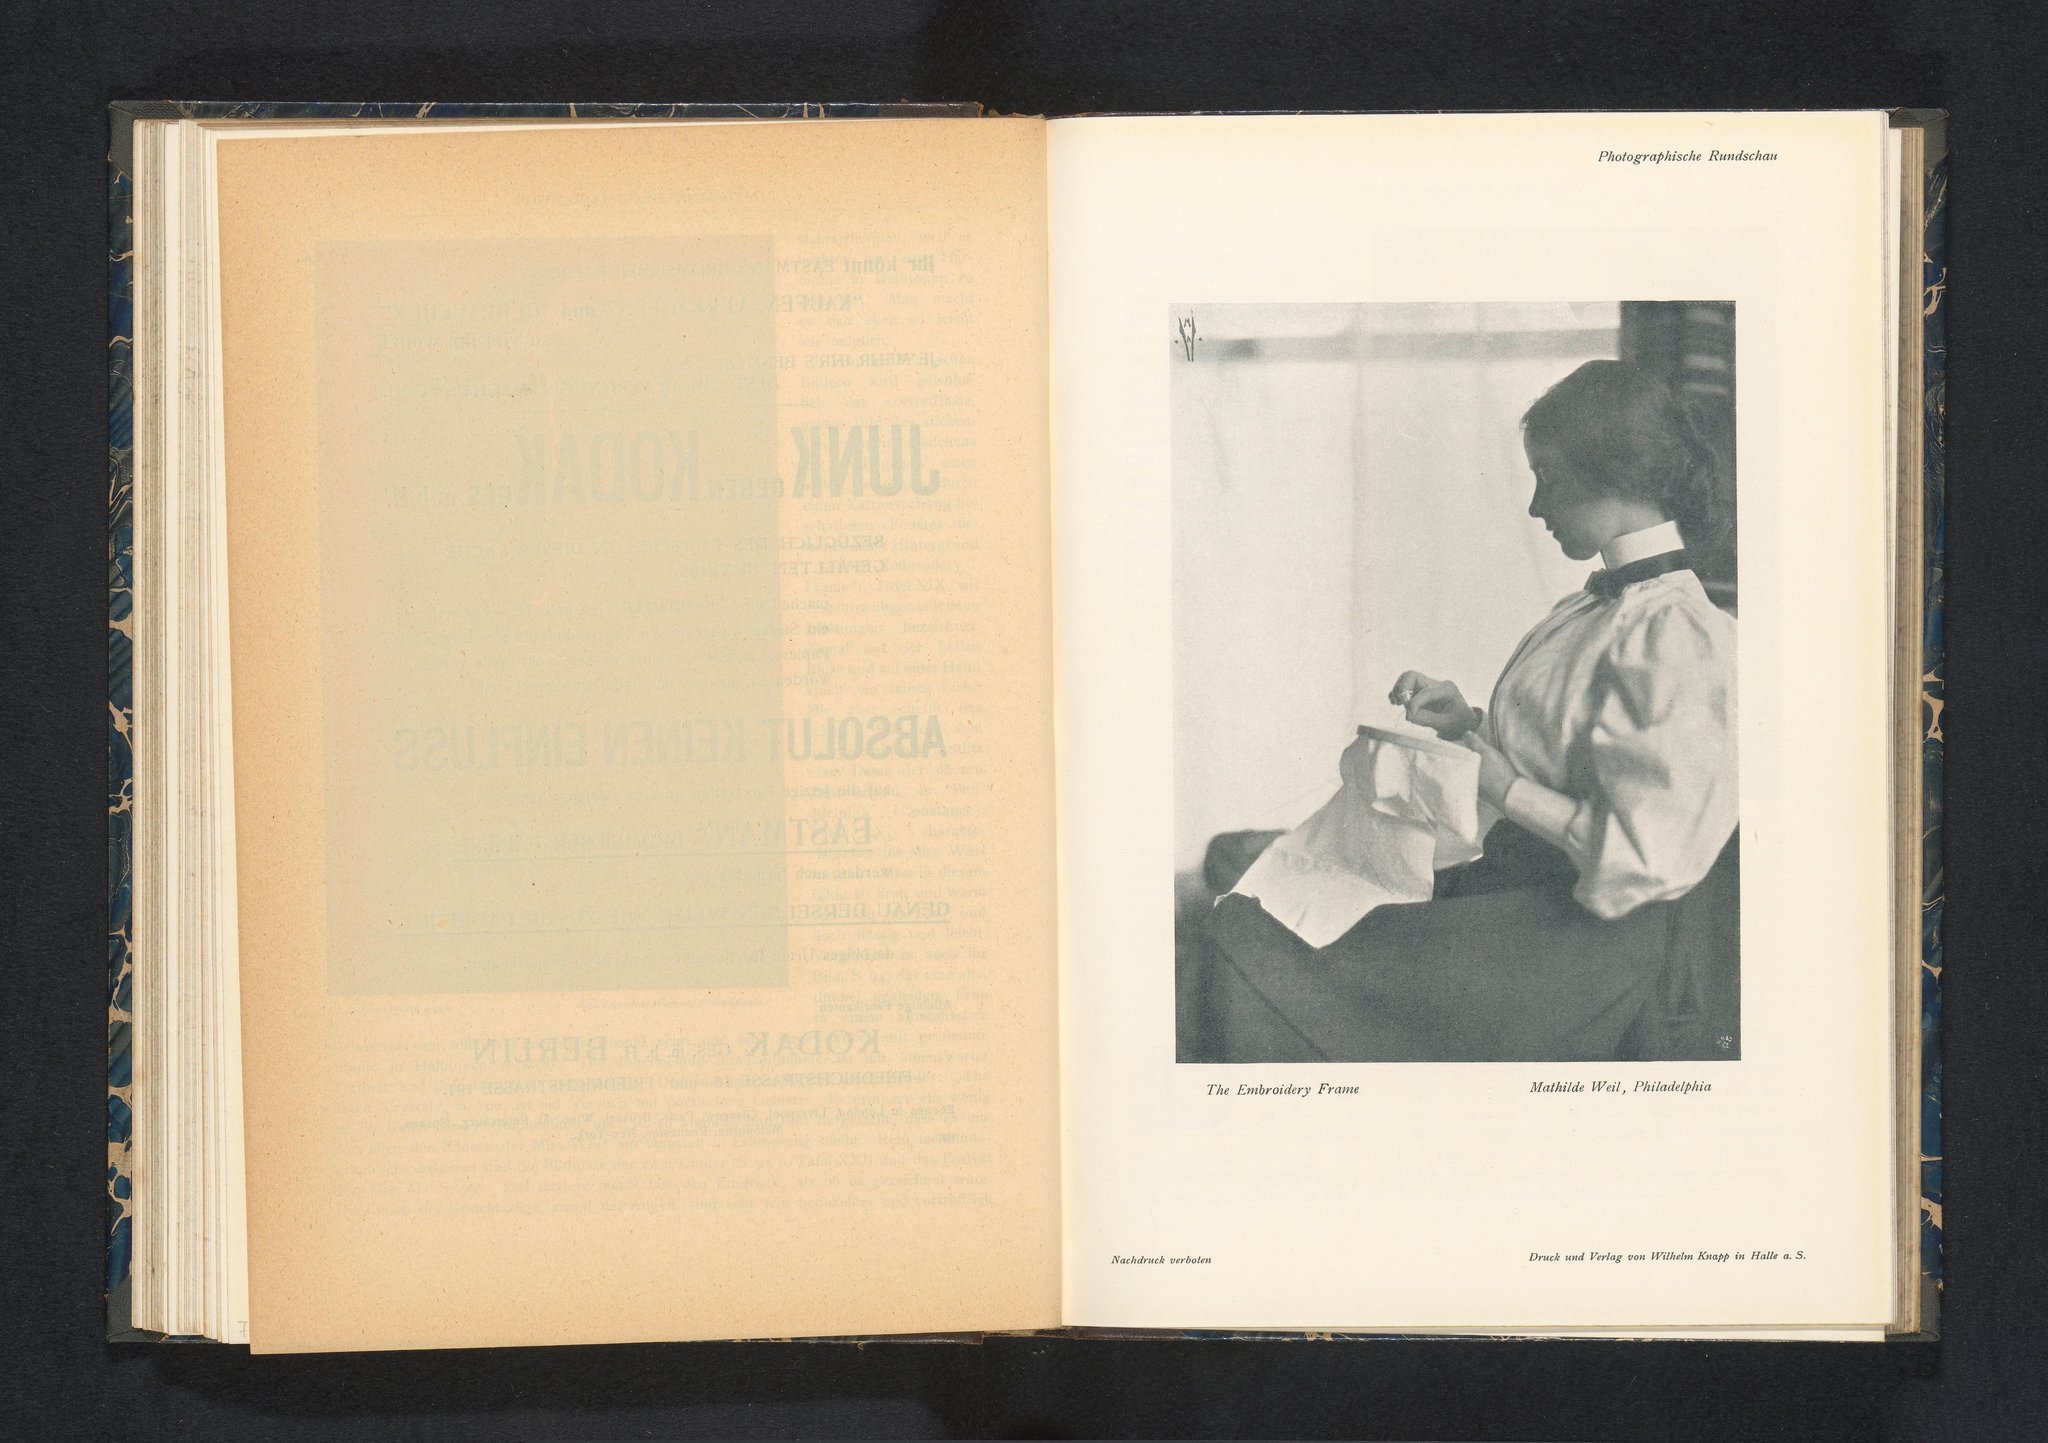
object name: page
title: The Embroidery Frame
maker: mathilde weil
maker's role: fotograaf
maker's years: 1872-1918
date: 1896-1901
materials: paper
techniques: autotype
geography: halle an der saale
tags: embroidering ~ textile industry, adult woman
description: Prent op tweede ongenummerde pagina na pagina 96.